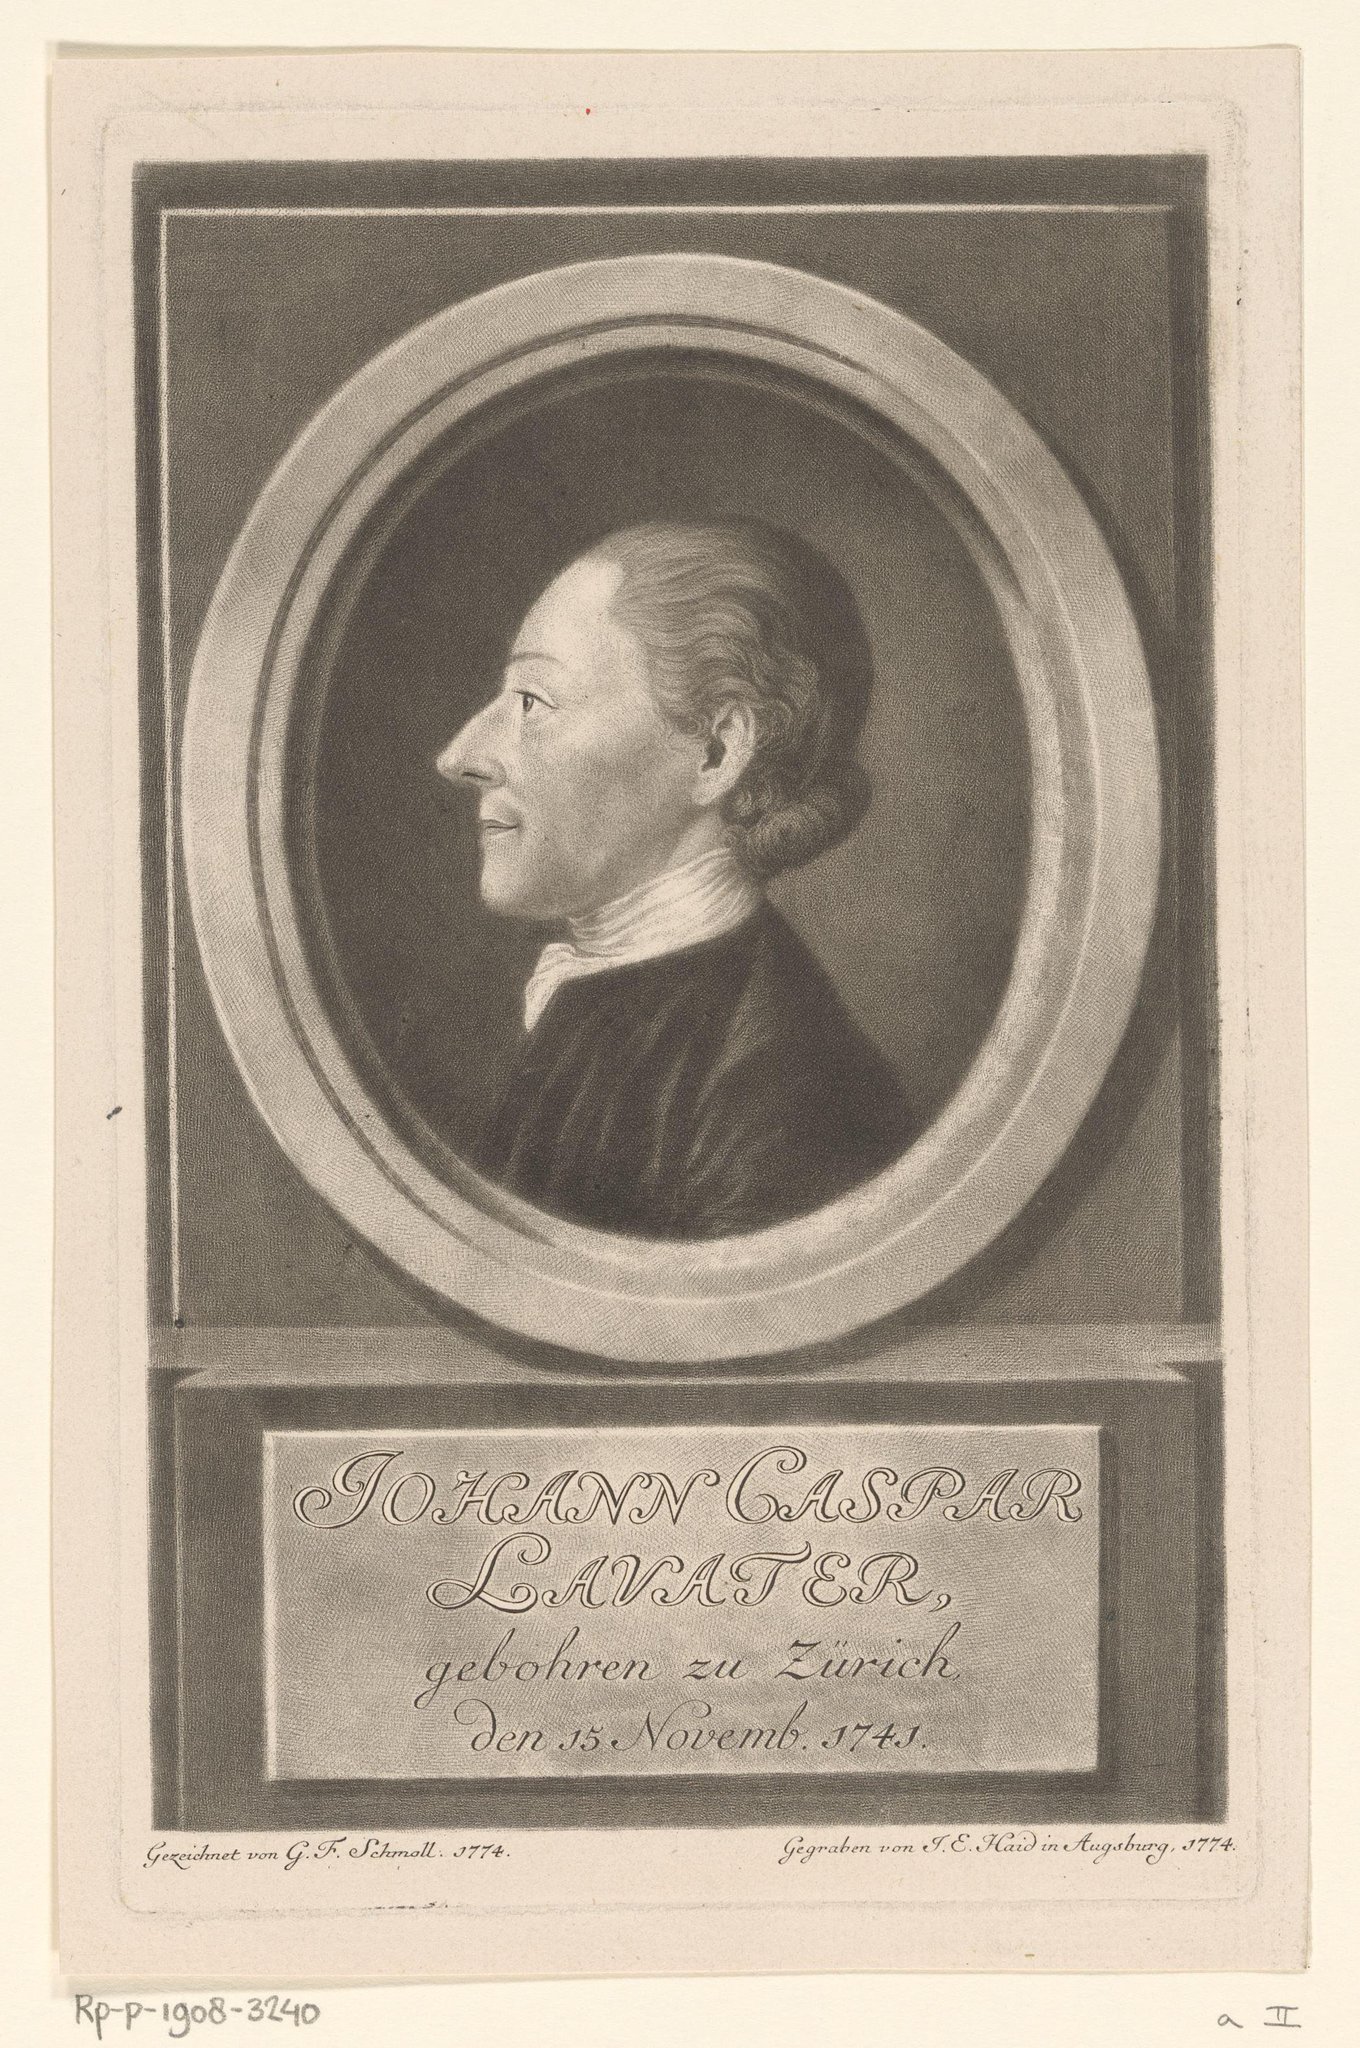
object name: print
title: Portret van Johann Caspar Lavater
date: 1774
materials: paper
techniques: mezzotint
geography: augsburg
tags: johann caspar lavater, historical persons, portrait of a writer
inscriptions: collector's mark: Lugt 2228